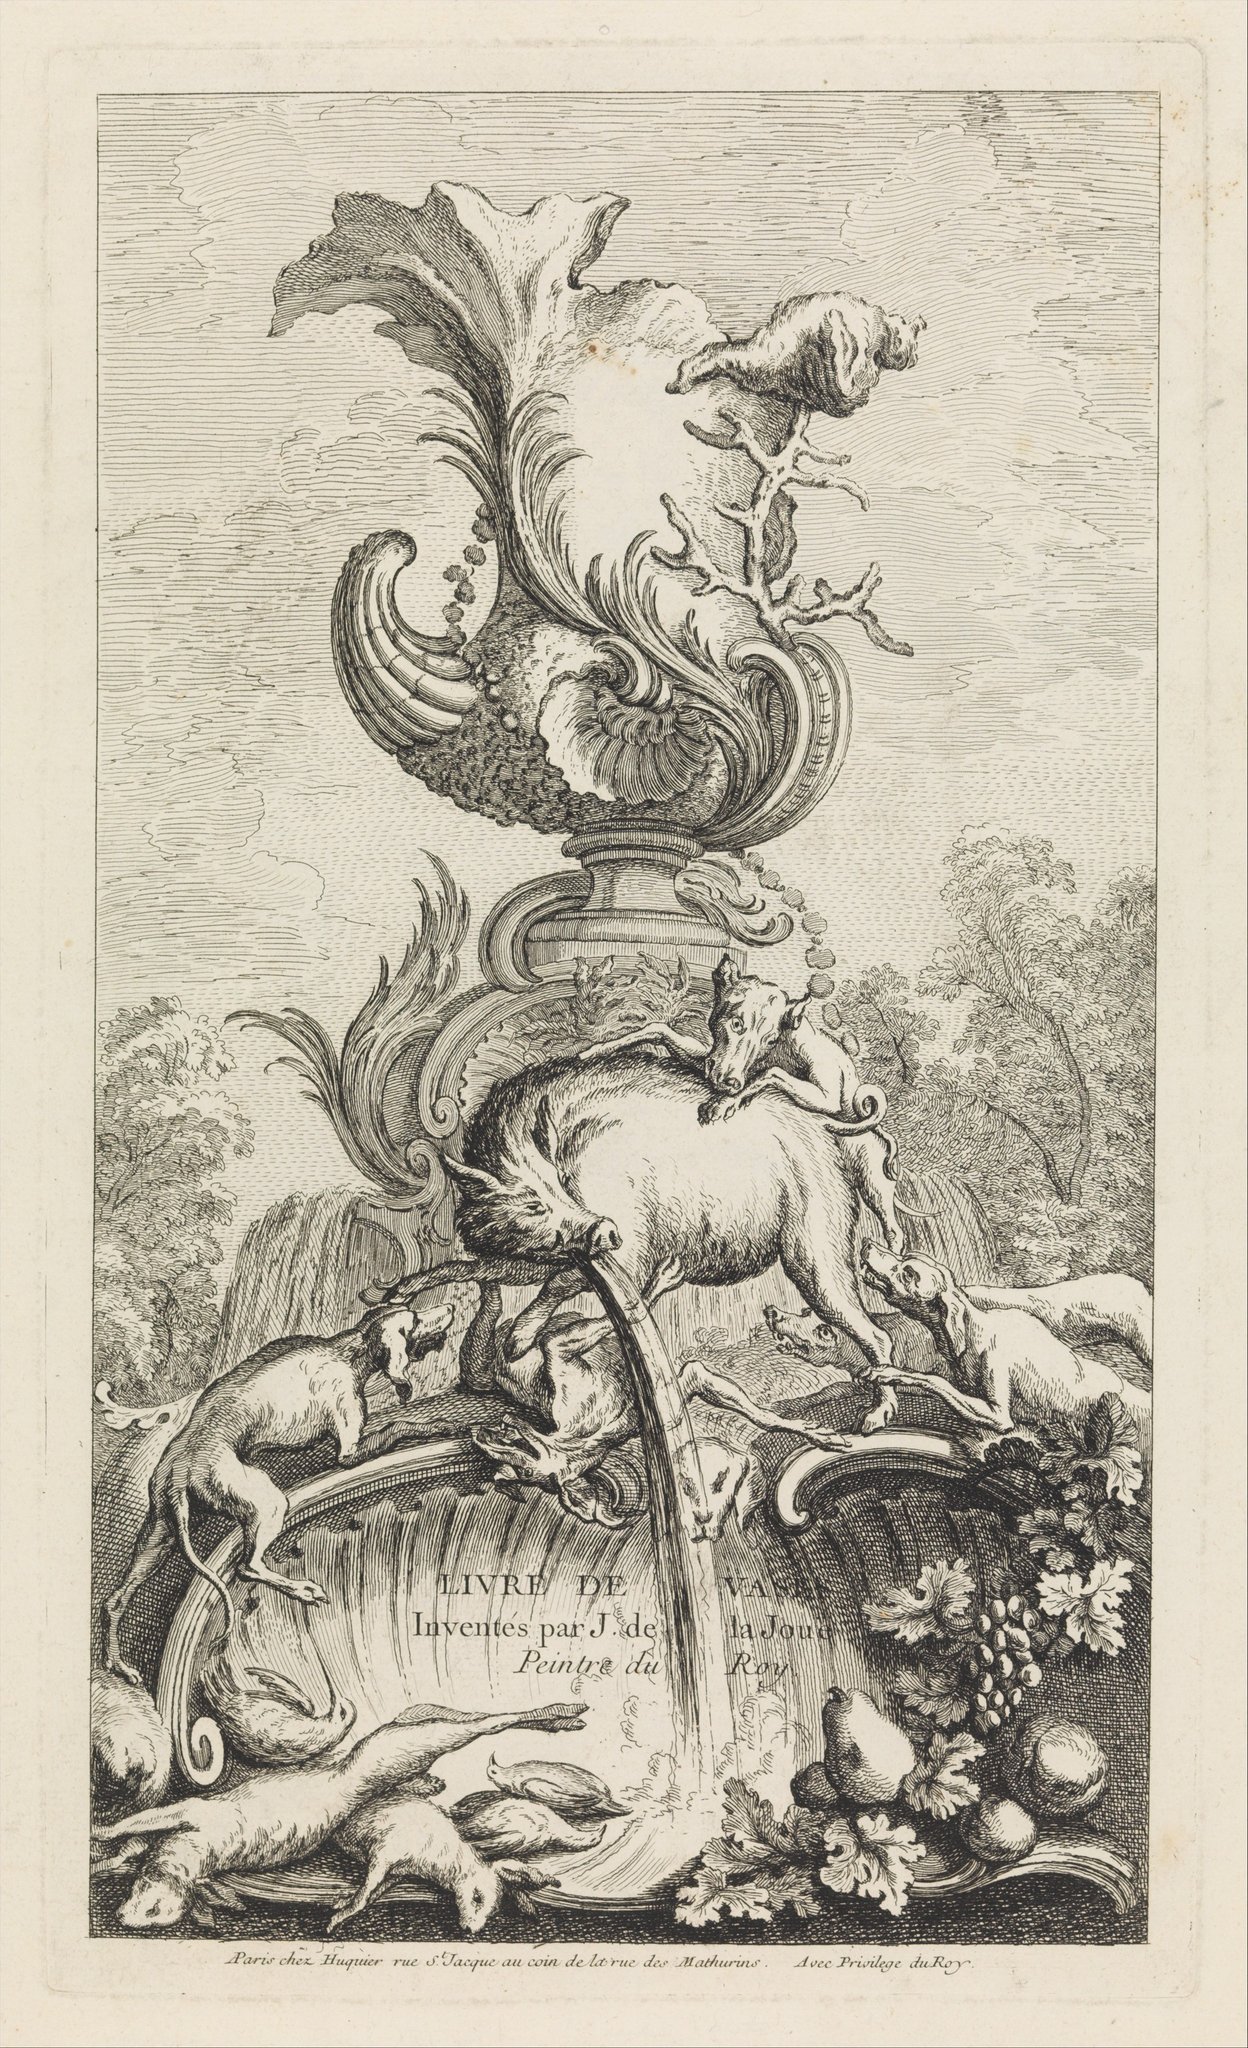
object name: book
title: Title Page from Book of Vases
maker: jacques de la joue the younger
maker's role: artist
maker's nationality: french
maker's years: 1686-1761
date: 1701-1800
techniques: etching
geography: france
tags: fruit,dogs,pigs,vases